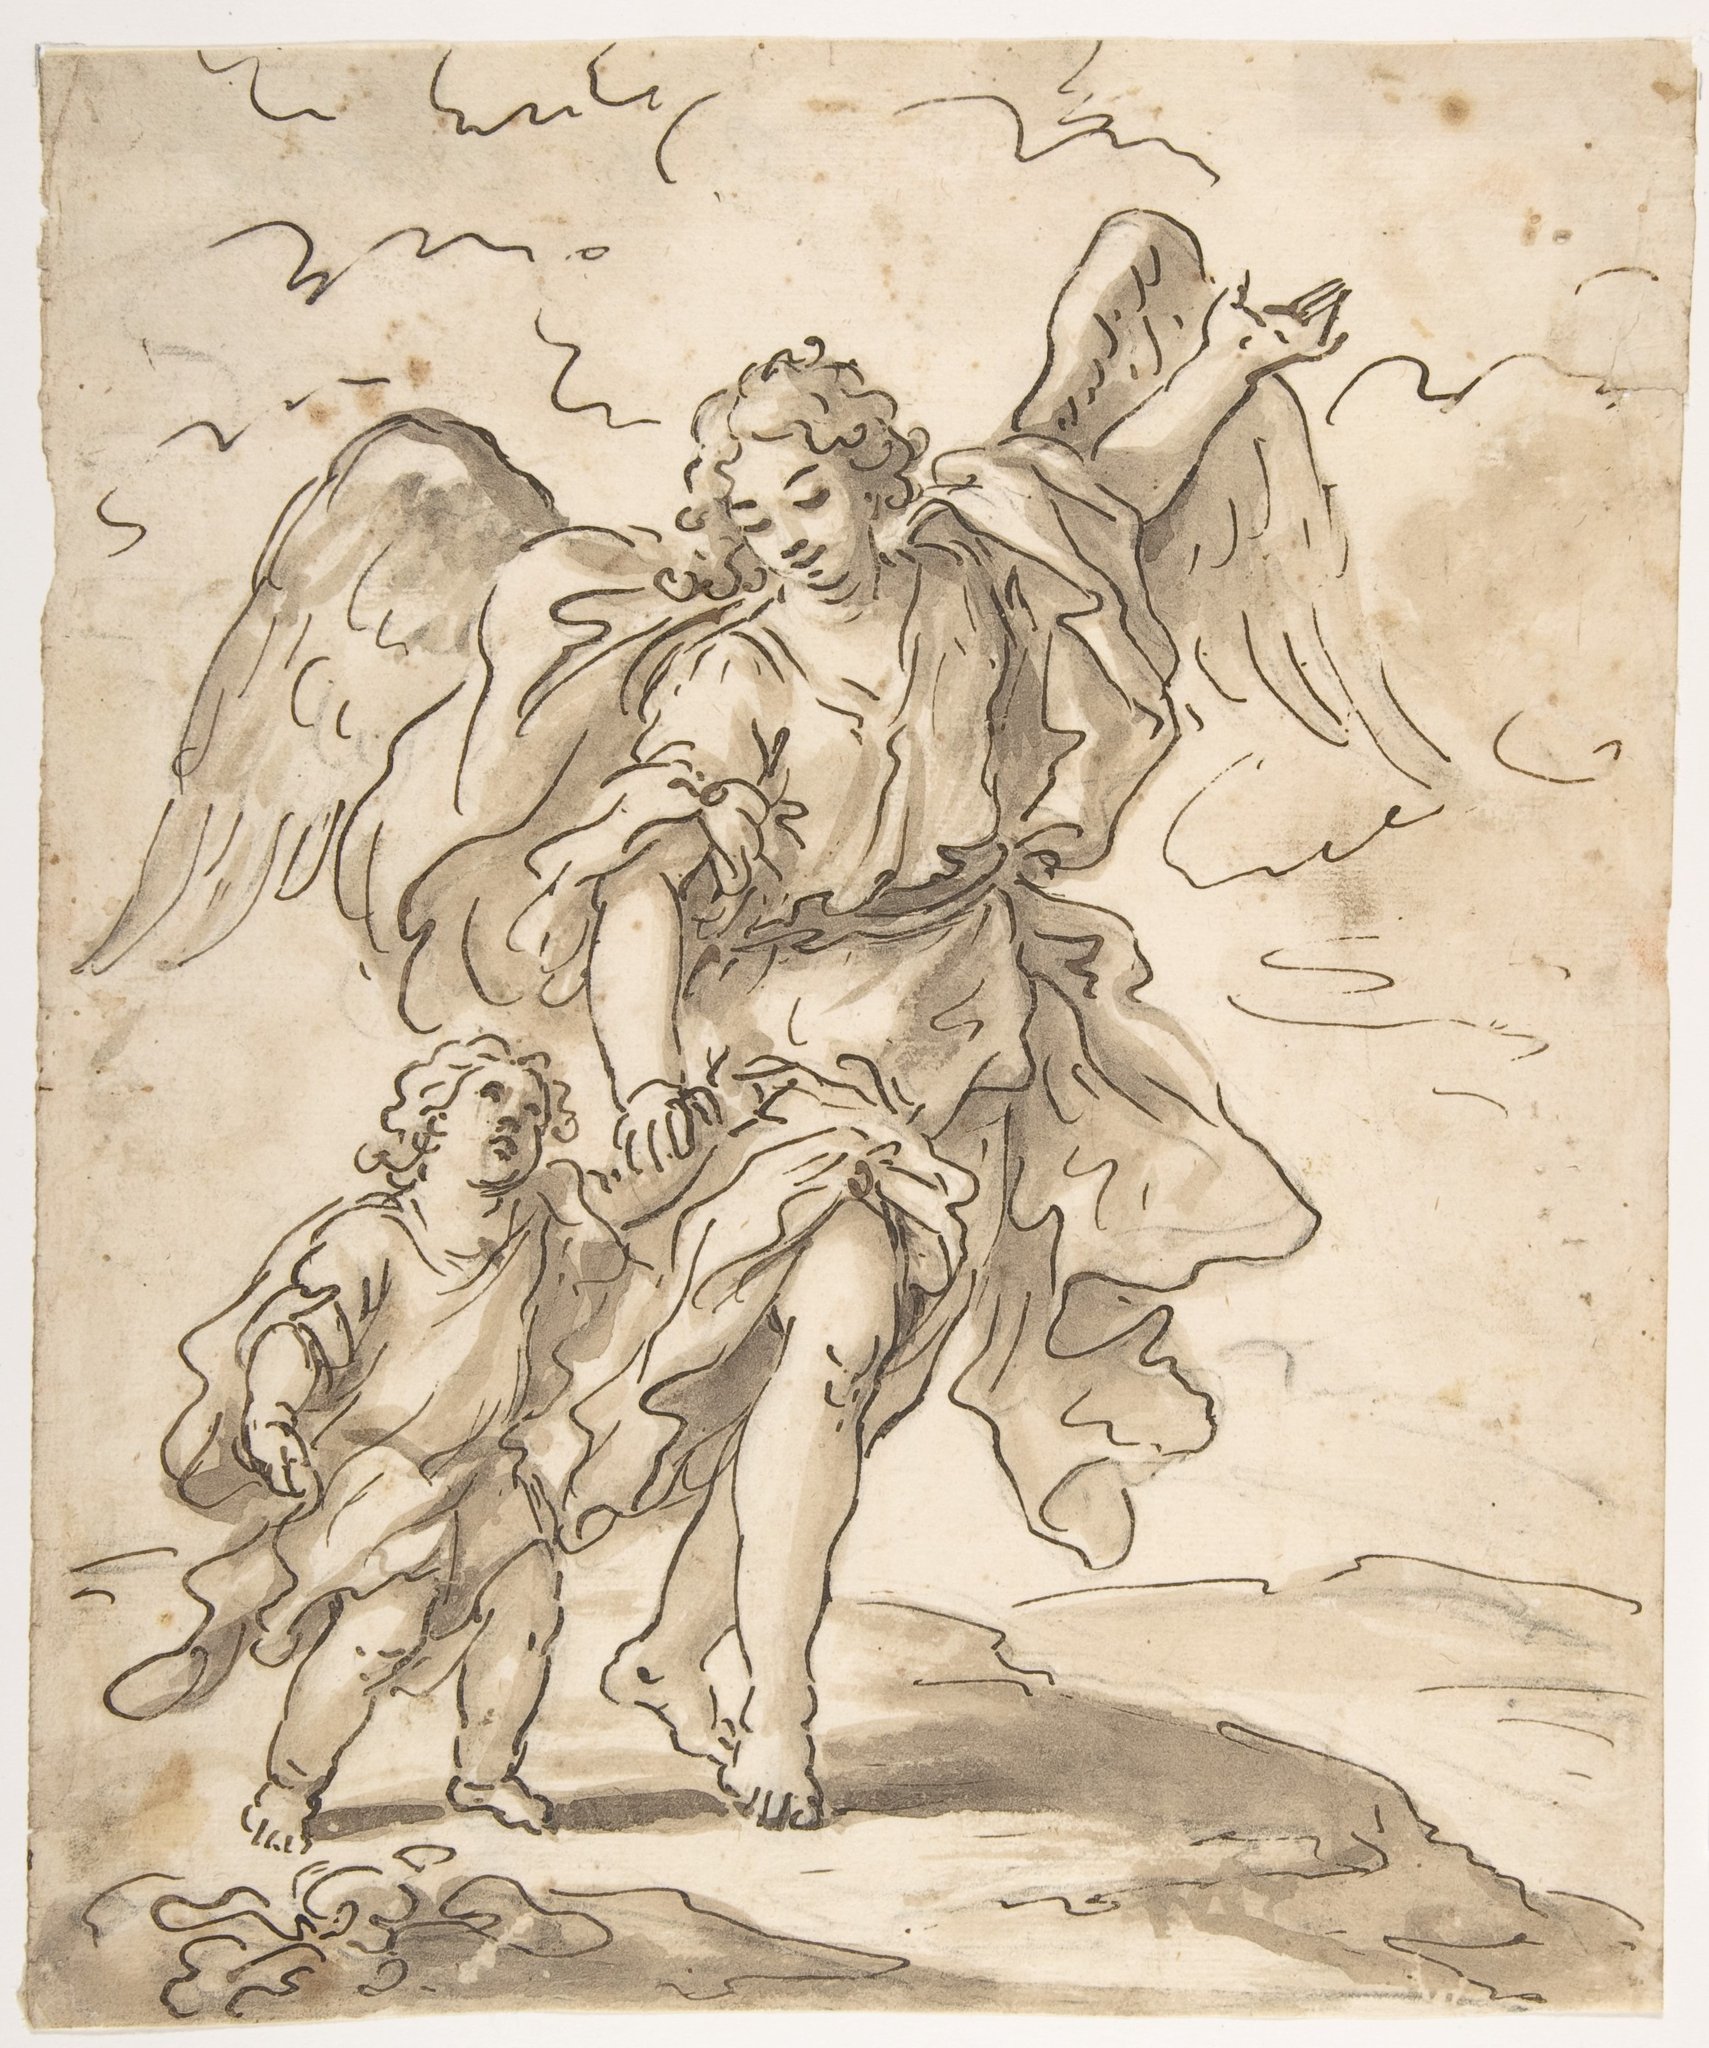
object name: drawing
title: Tobias and the Angel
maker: paolo de matteis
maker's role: artist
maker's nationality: italian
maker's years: 1662-1728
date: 1662-1728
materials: chalk, ink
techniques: brush, pen, wash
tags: children,angels